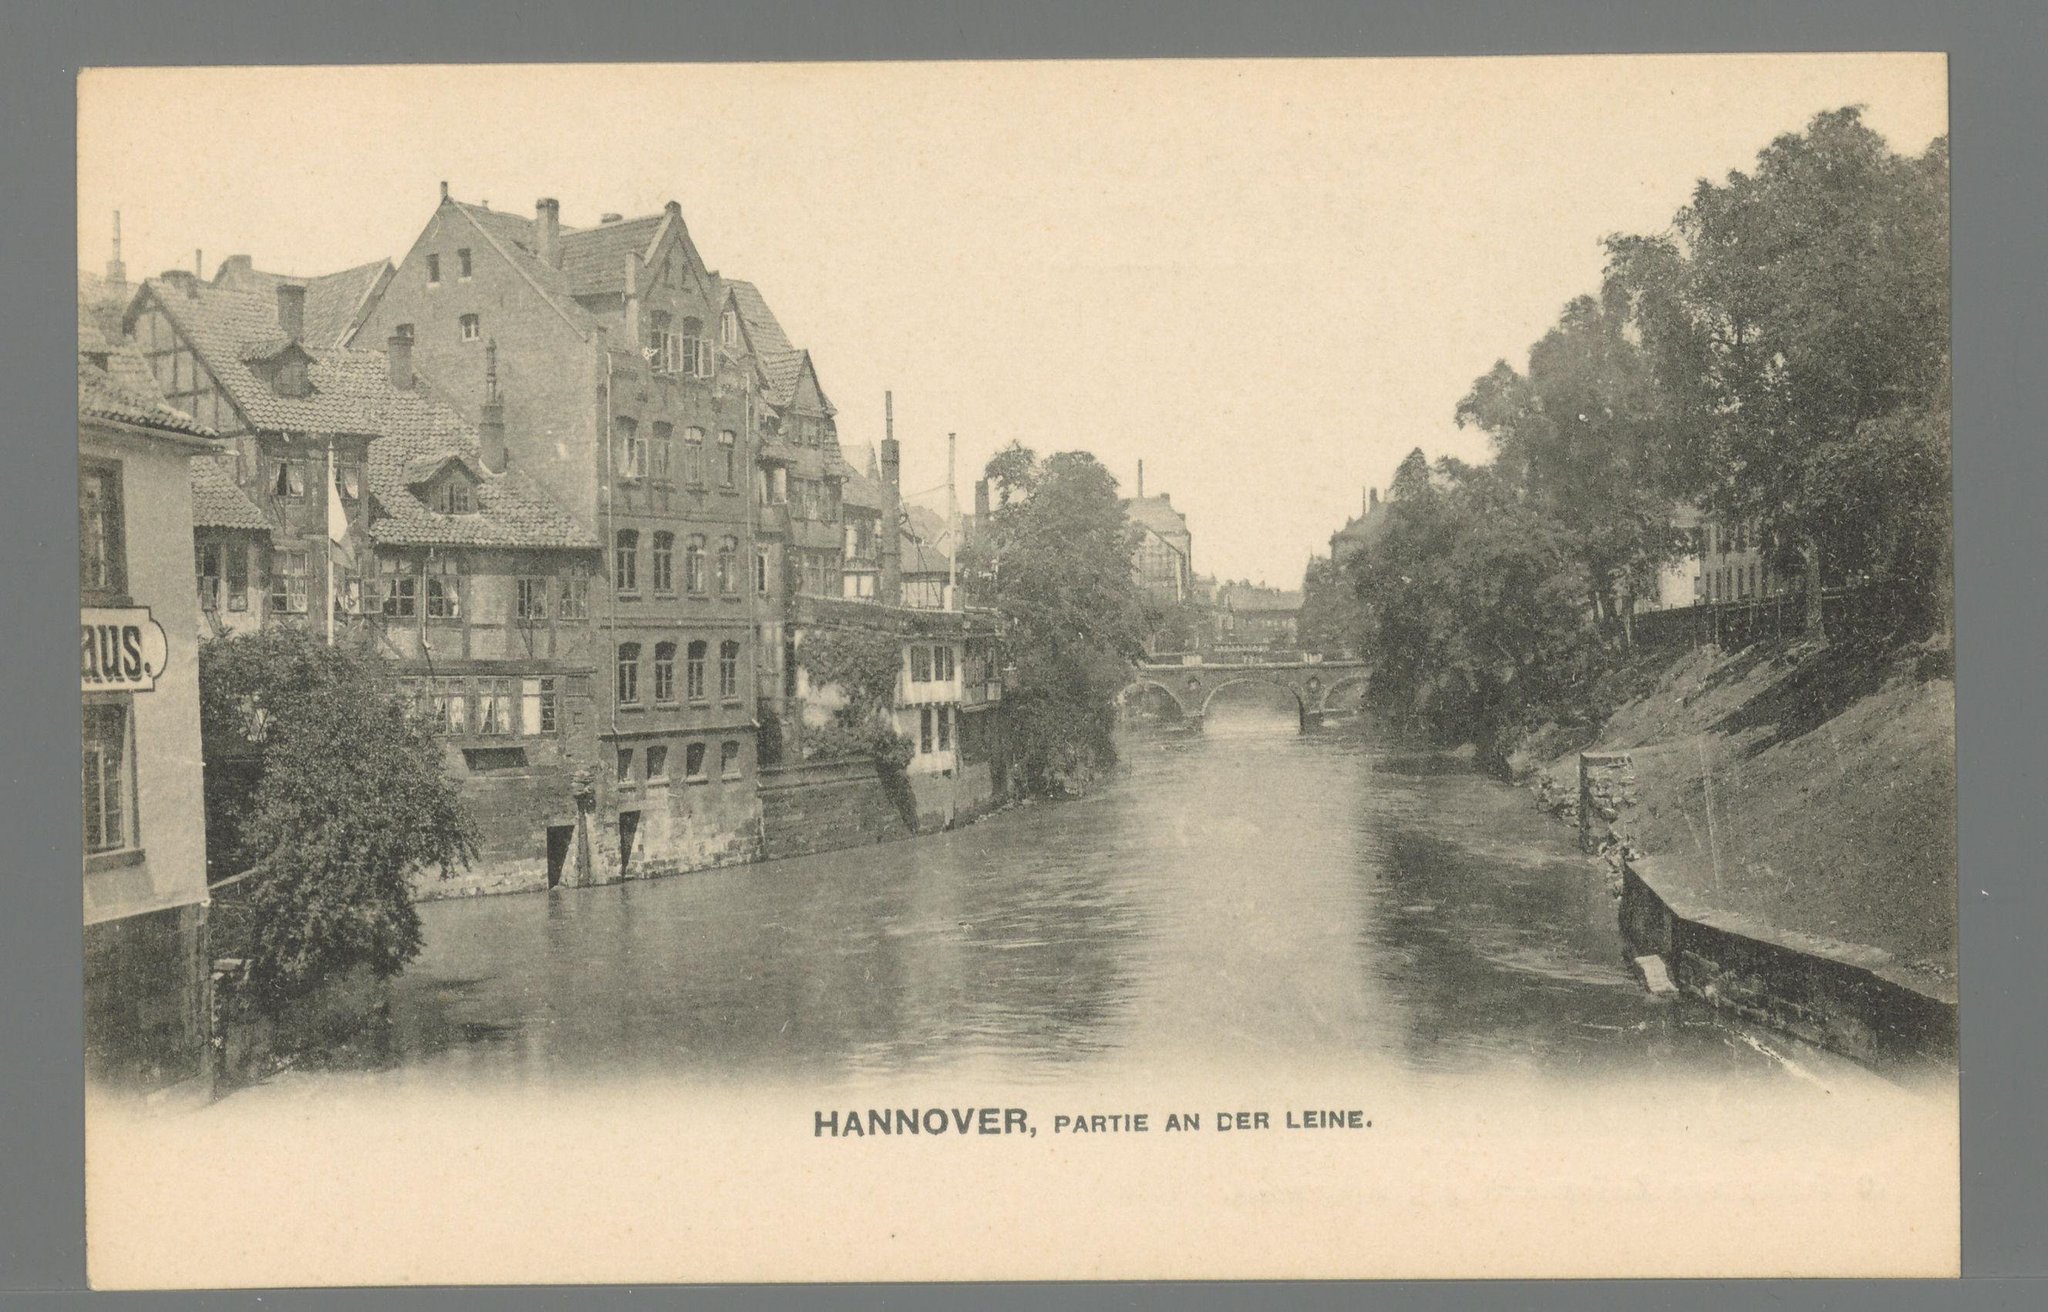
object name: photomechanical print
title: Hannover, Partie an der Leine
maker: Anonymous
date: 1906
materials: cardboard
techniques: photograph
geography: darmstadt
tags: canals, waters (in city), bridge in city across river, canal, etc., street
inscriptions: date